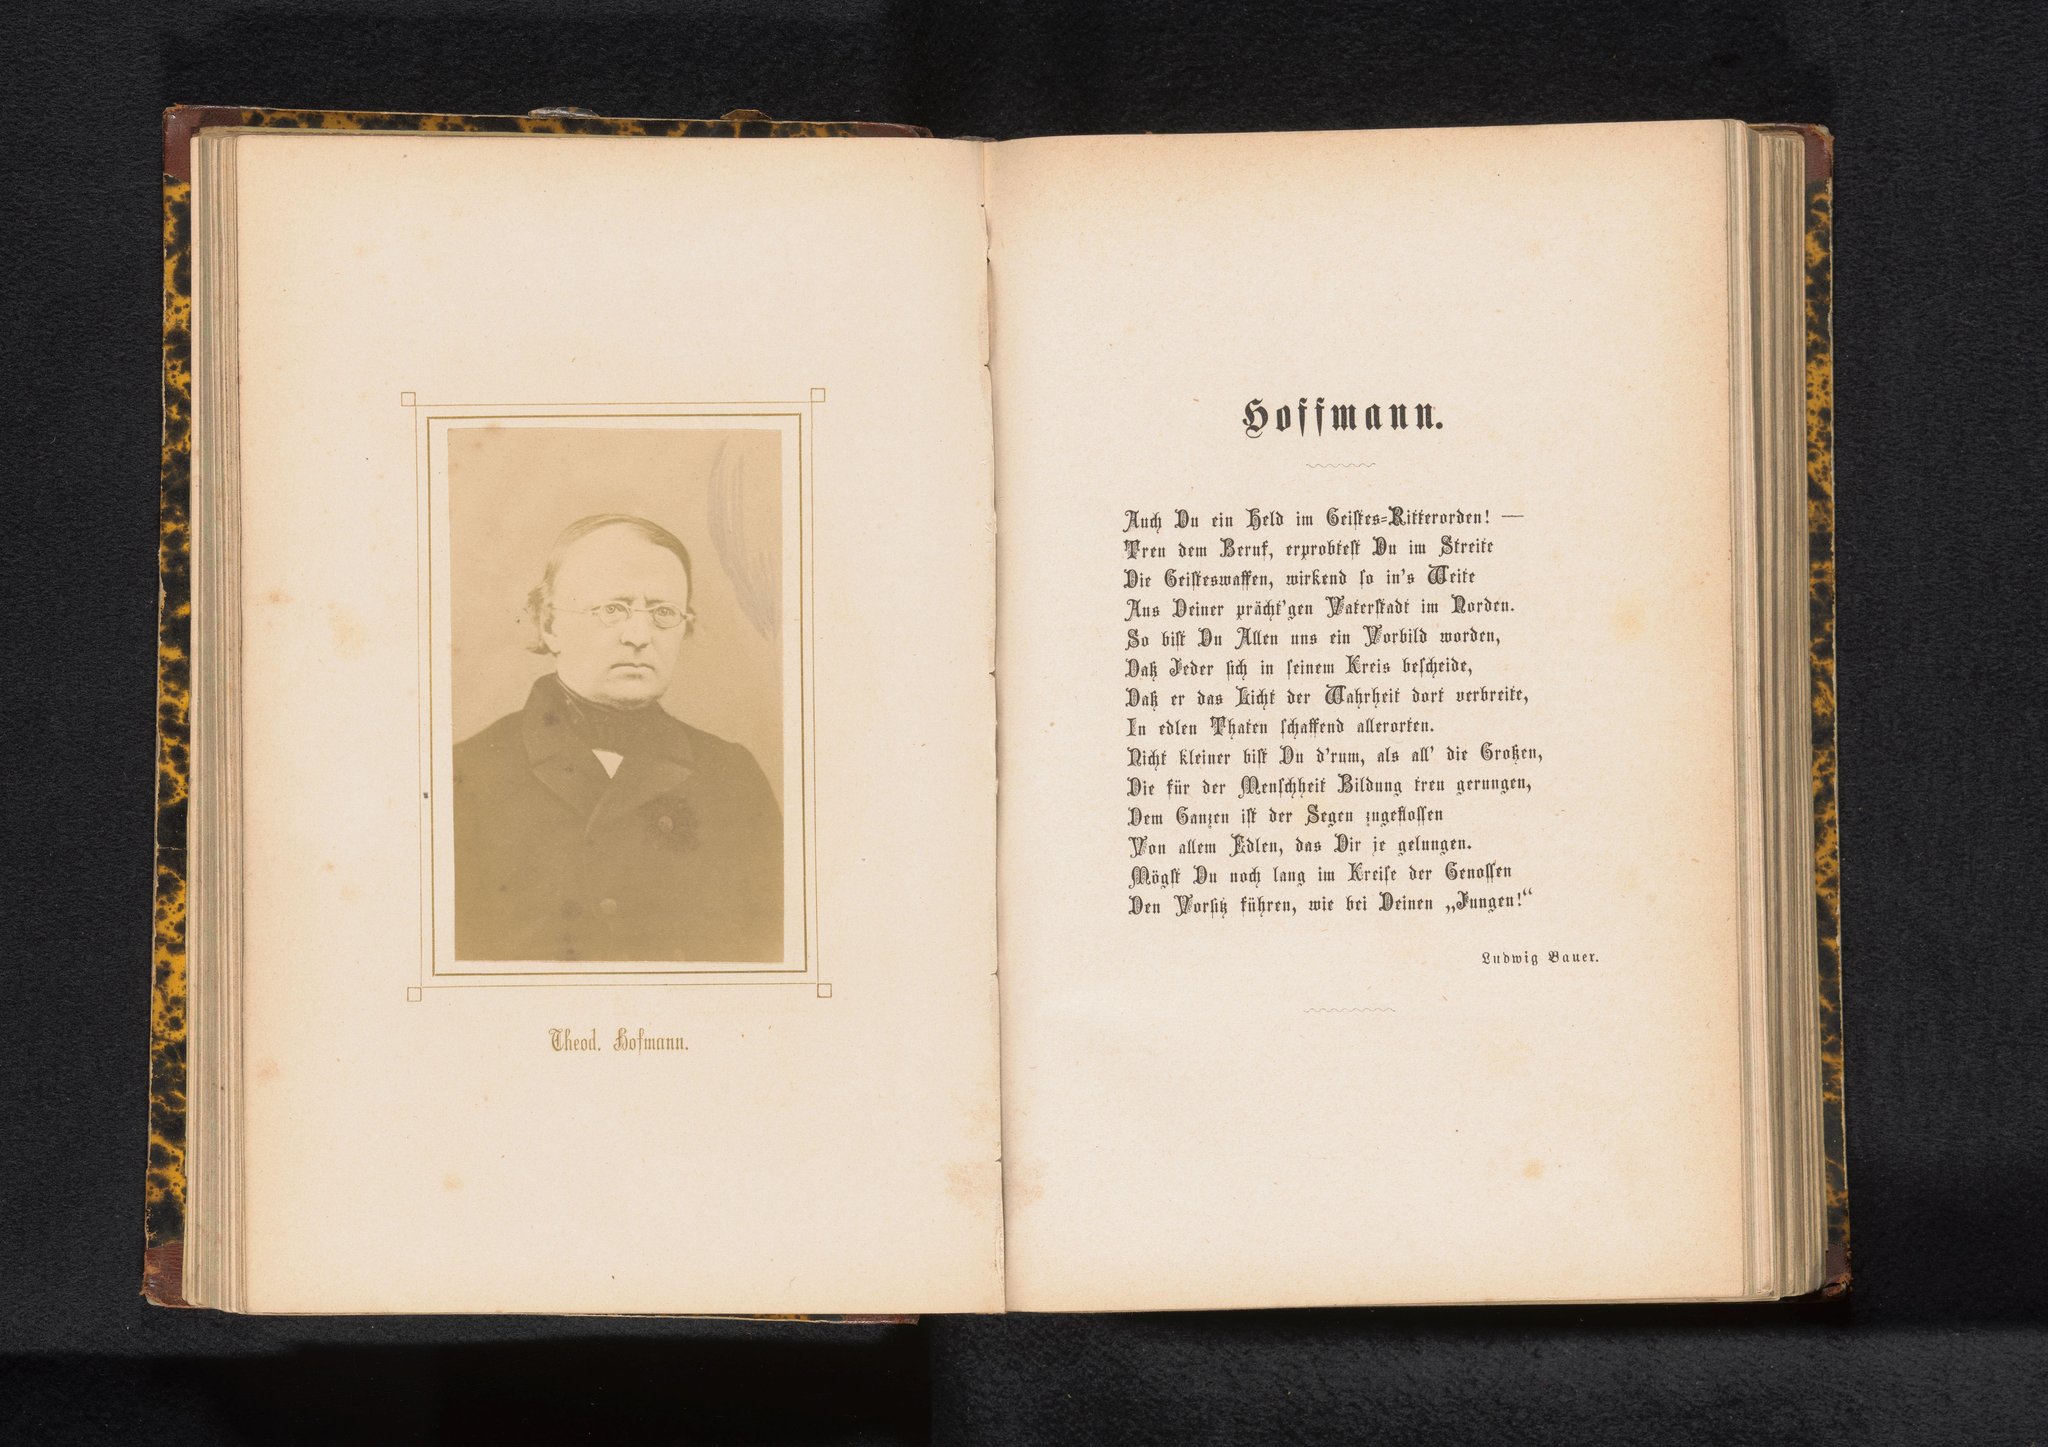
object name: page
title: Theod. Hofmann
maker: Anonymous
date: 1862-1872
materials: photographic support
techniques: albumen print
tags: priest, priest (roman catholic), adult man